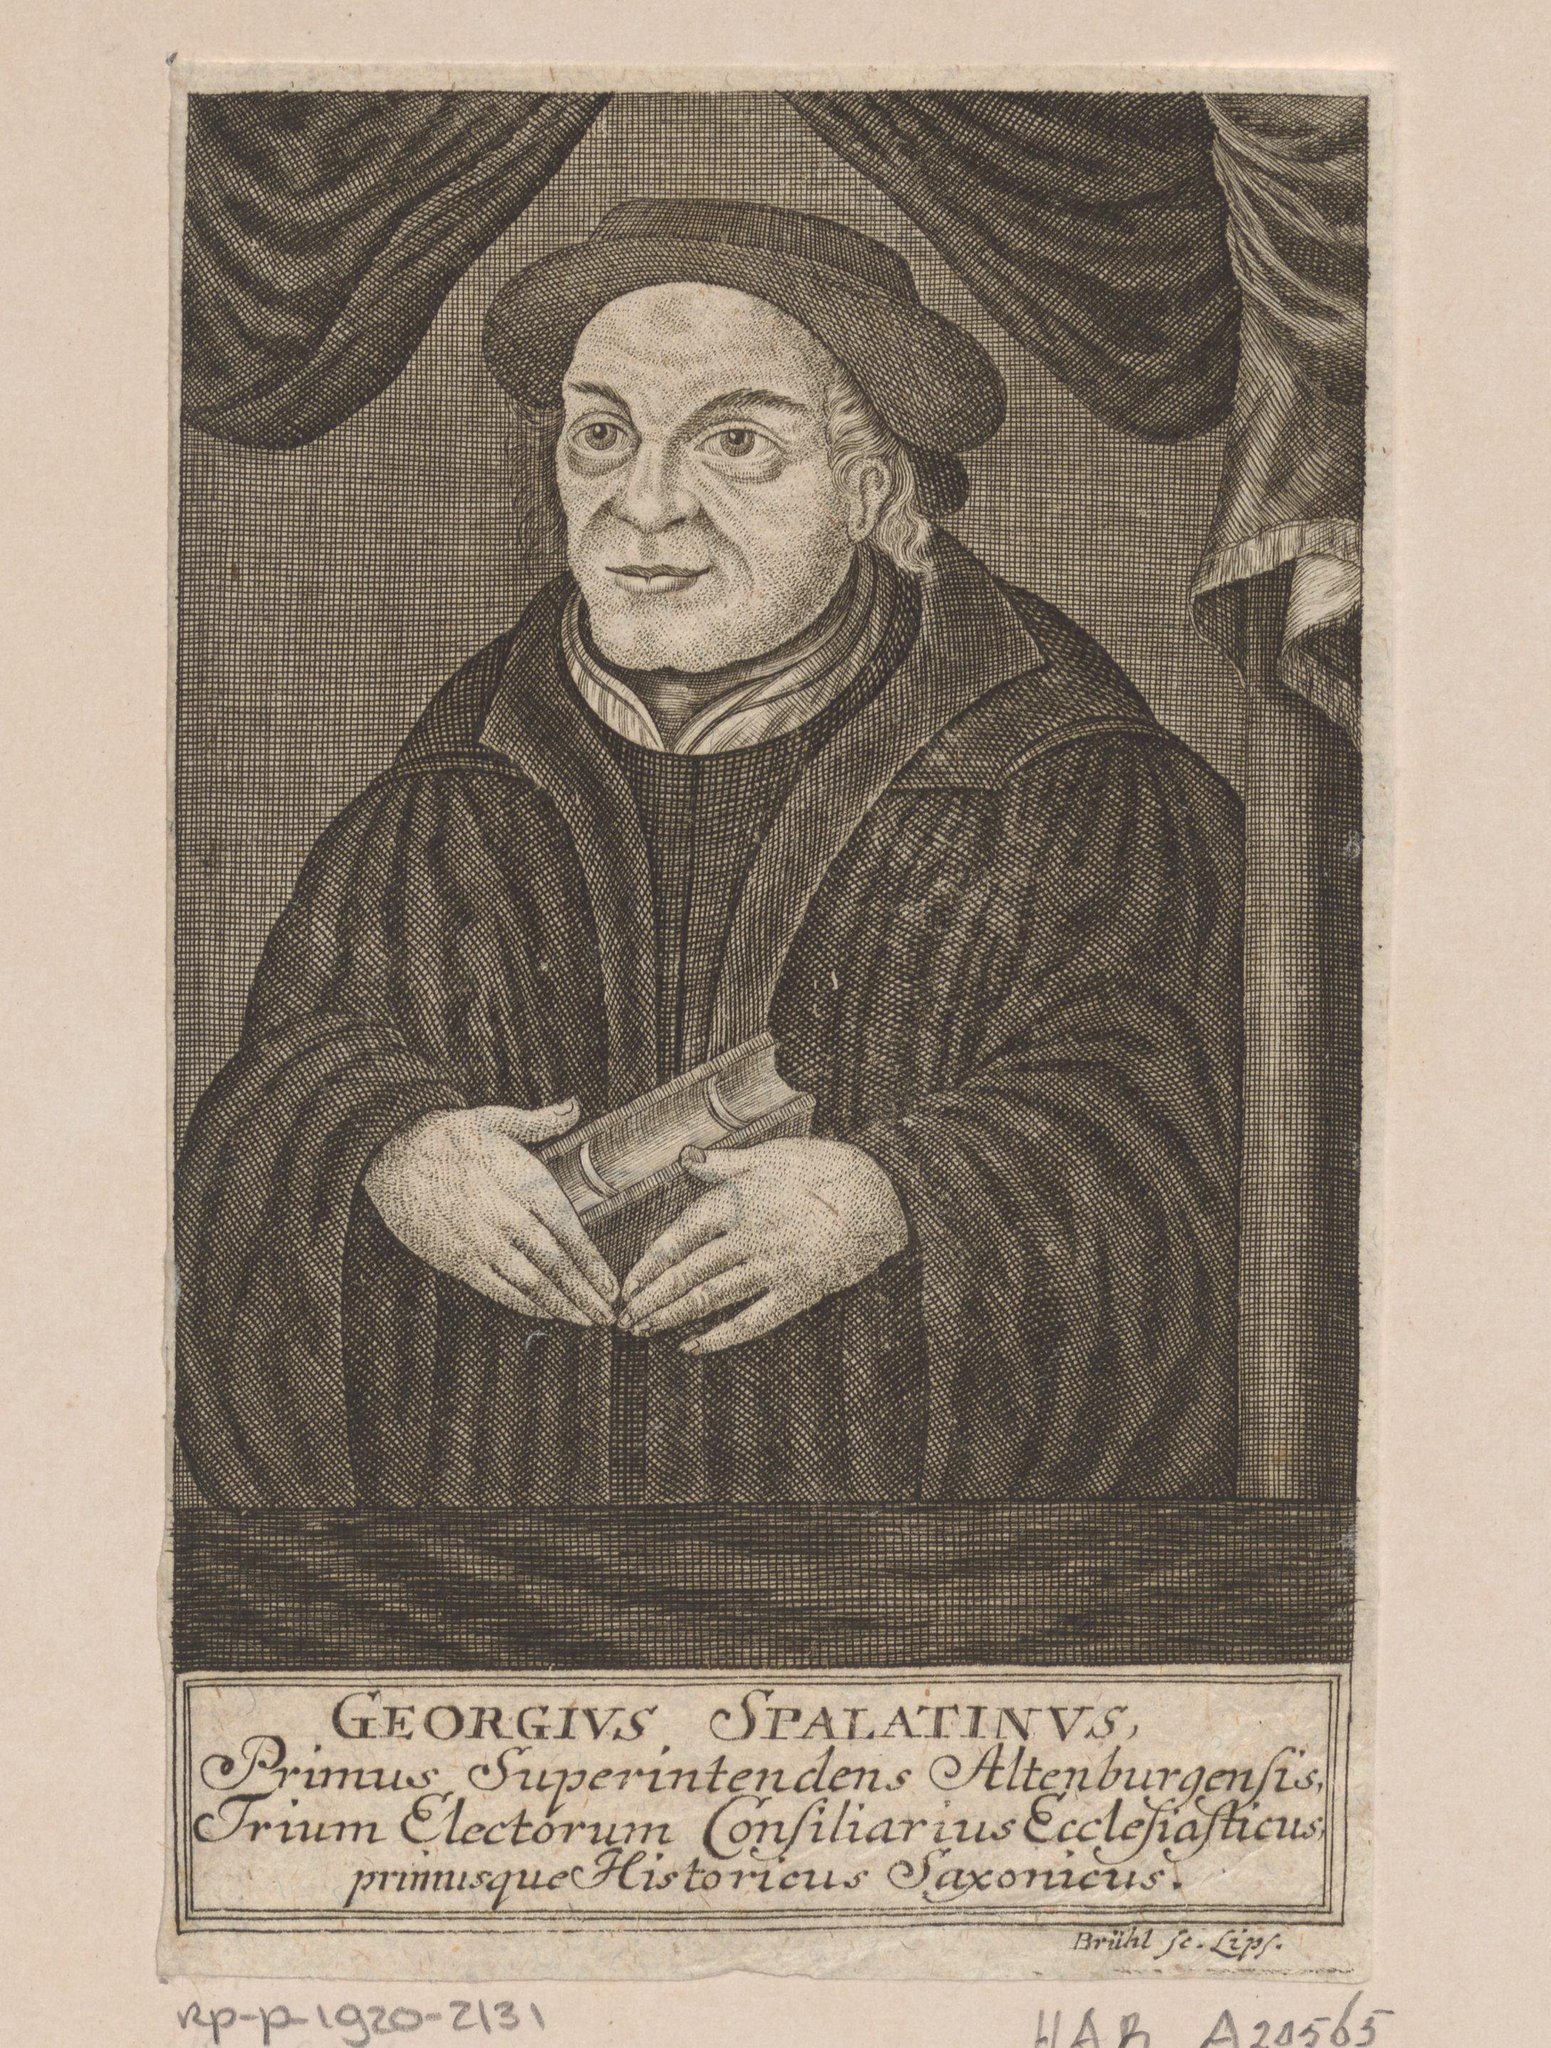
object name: print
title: Portret van Georg Spalatin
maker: johann benjamin brühl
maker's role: print maker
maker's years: 1691-1763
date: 1730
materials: paper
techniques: engraving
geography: leipzig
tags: priest, theologian, historical persons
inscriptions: collector's mark: Lugt 2228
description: Prent mogelijk uit: Fortgesetzte Sammlung Von Alten und Neuen Theologischen Sachen (...) Zweyter Beytrag Auf das Jahr 1730. Leipzig: erven Johann Friedrich Braun, 1730.